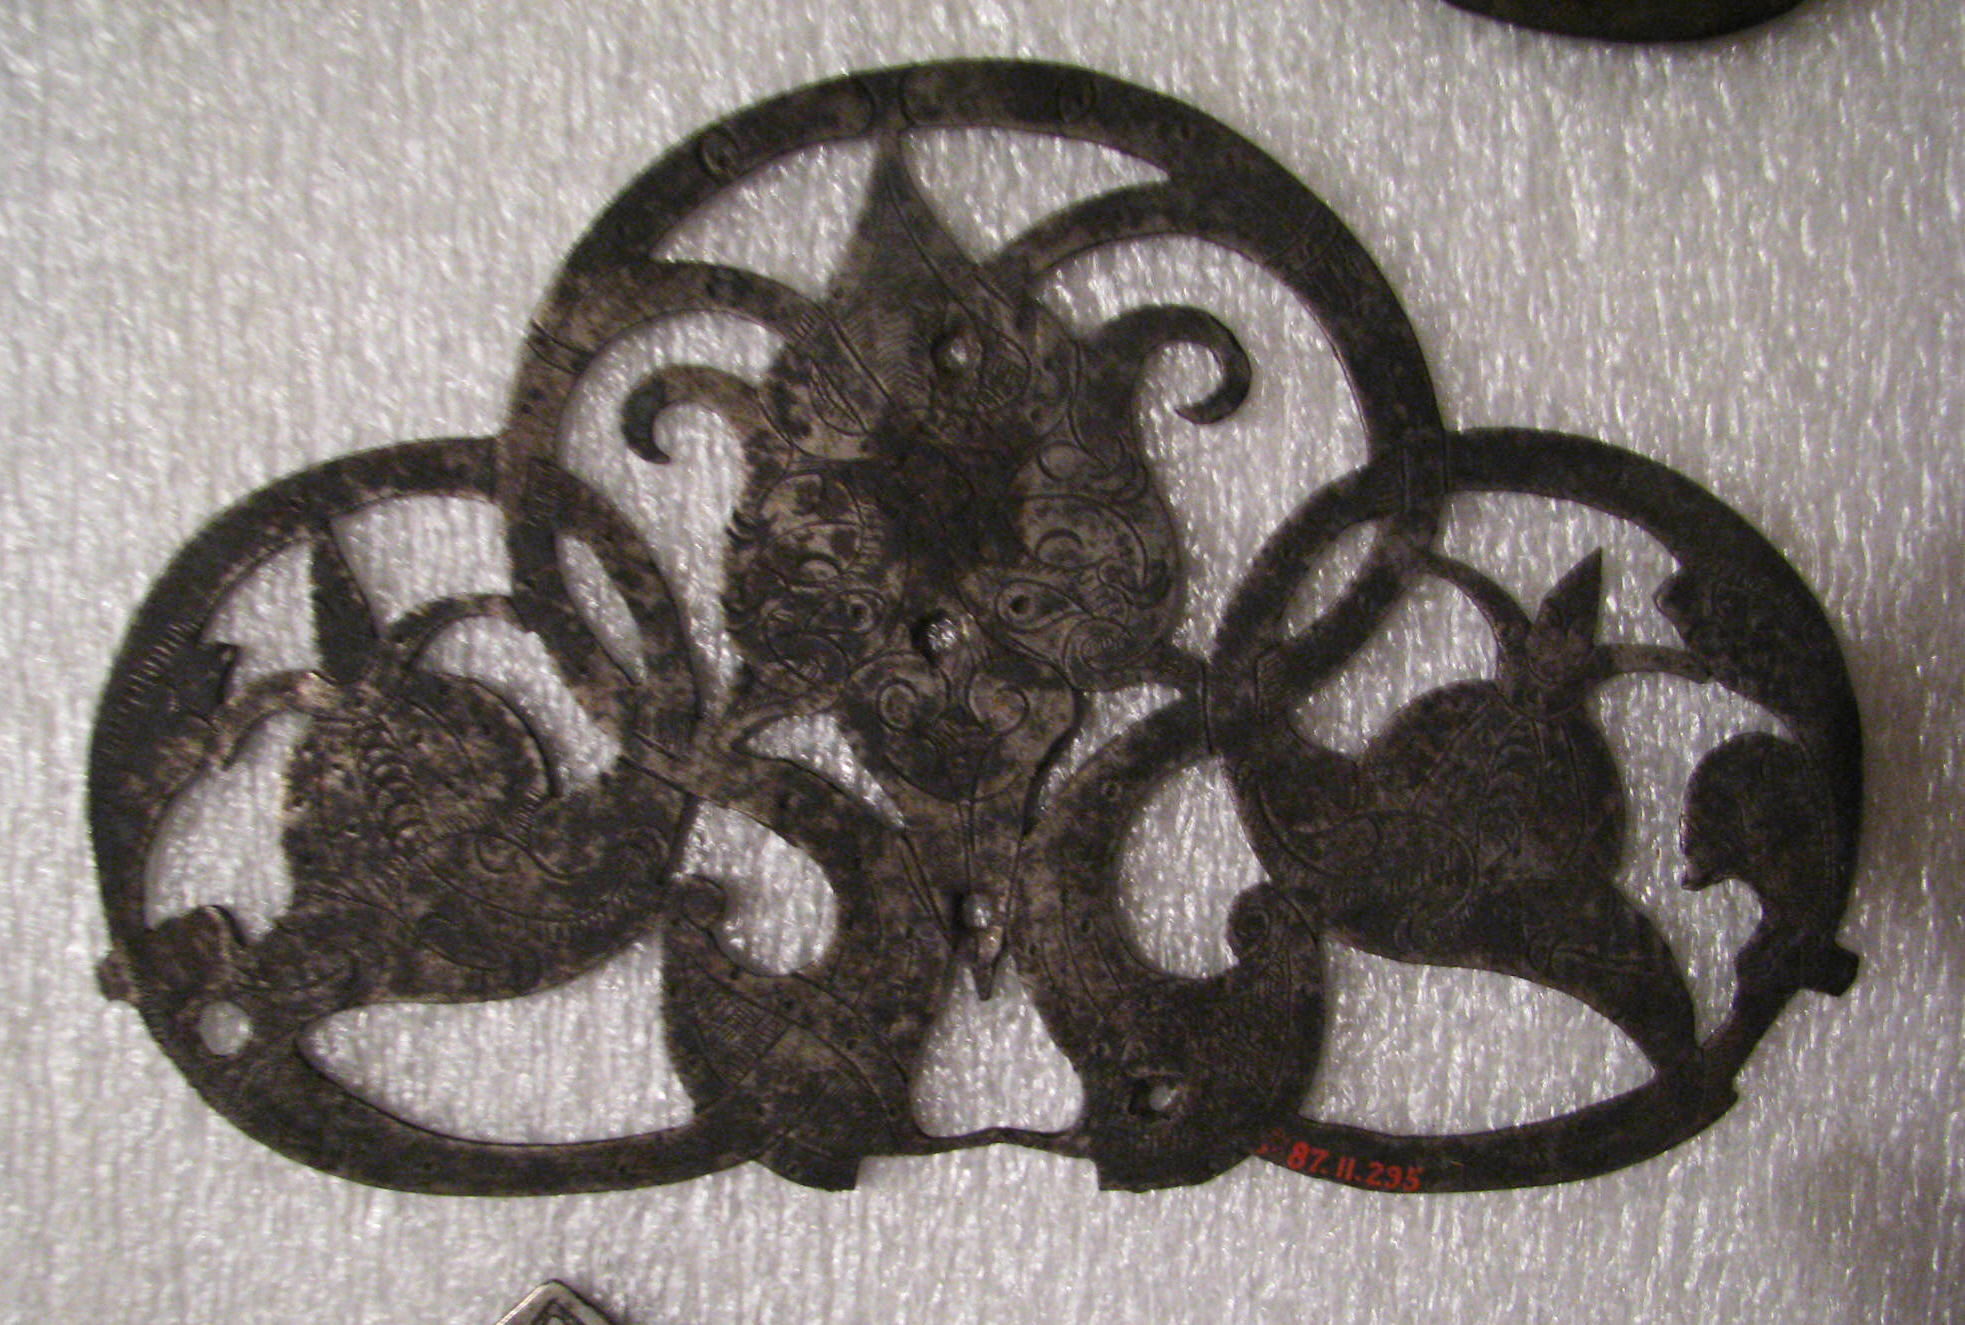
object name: plaque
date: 1567-1600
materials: iron